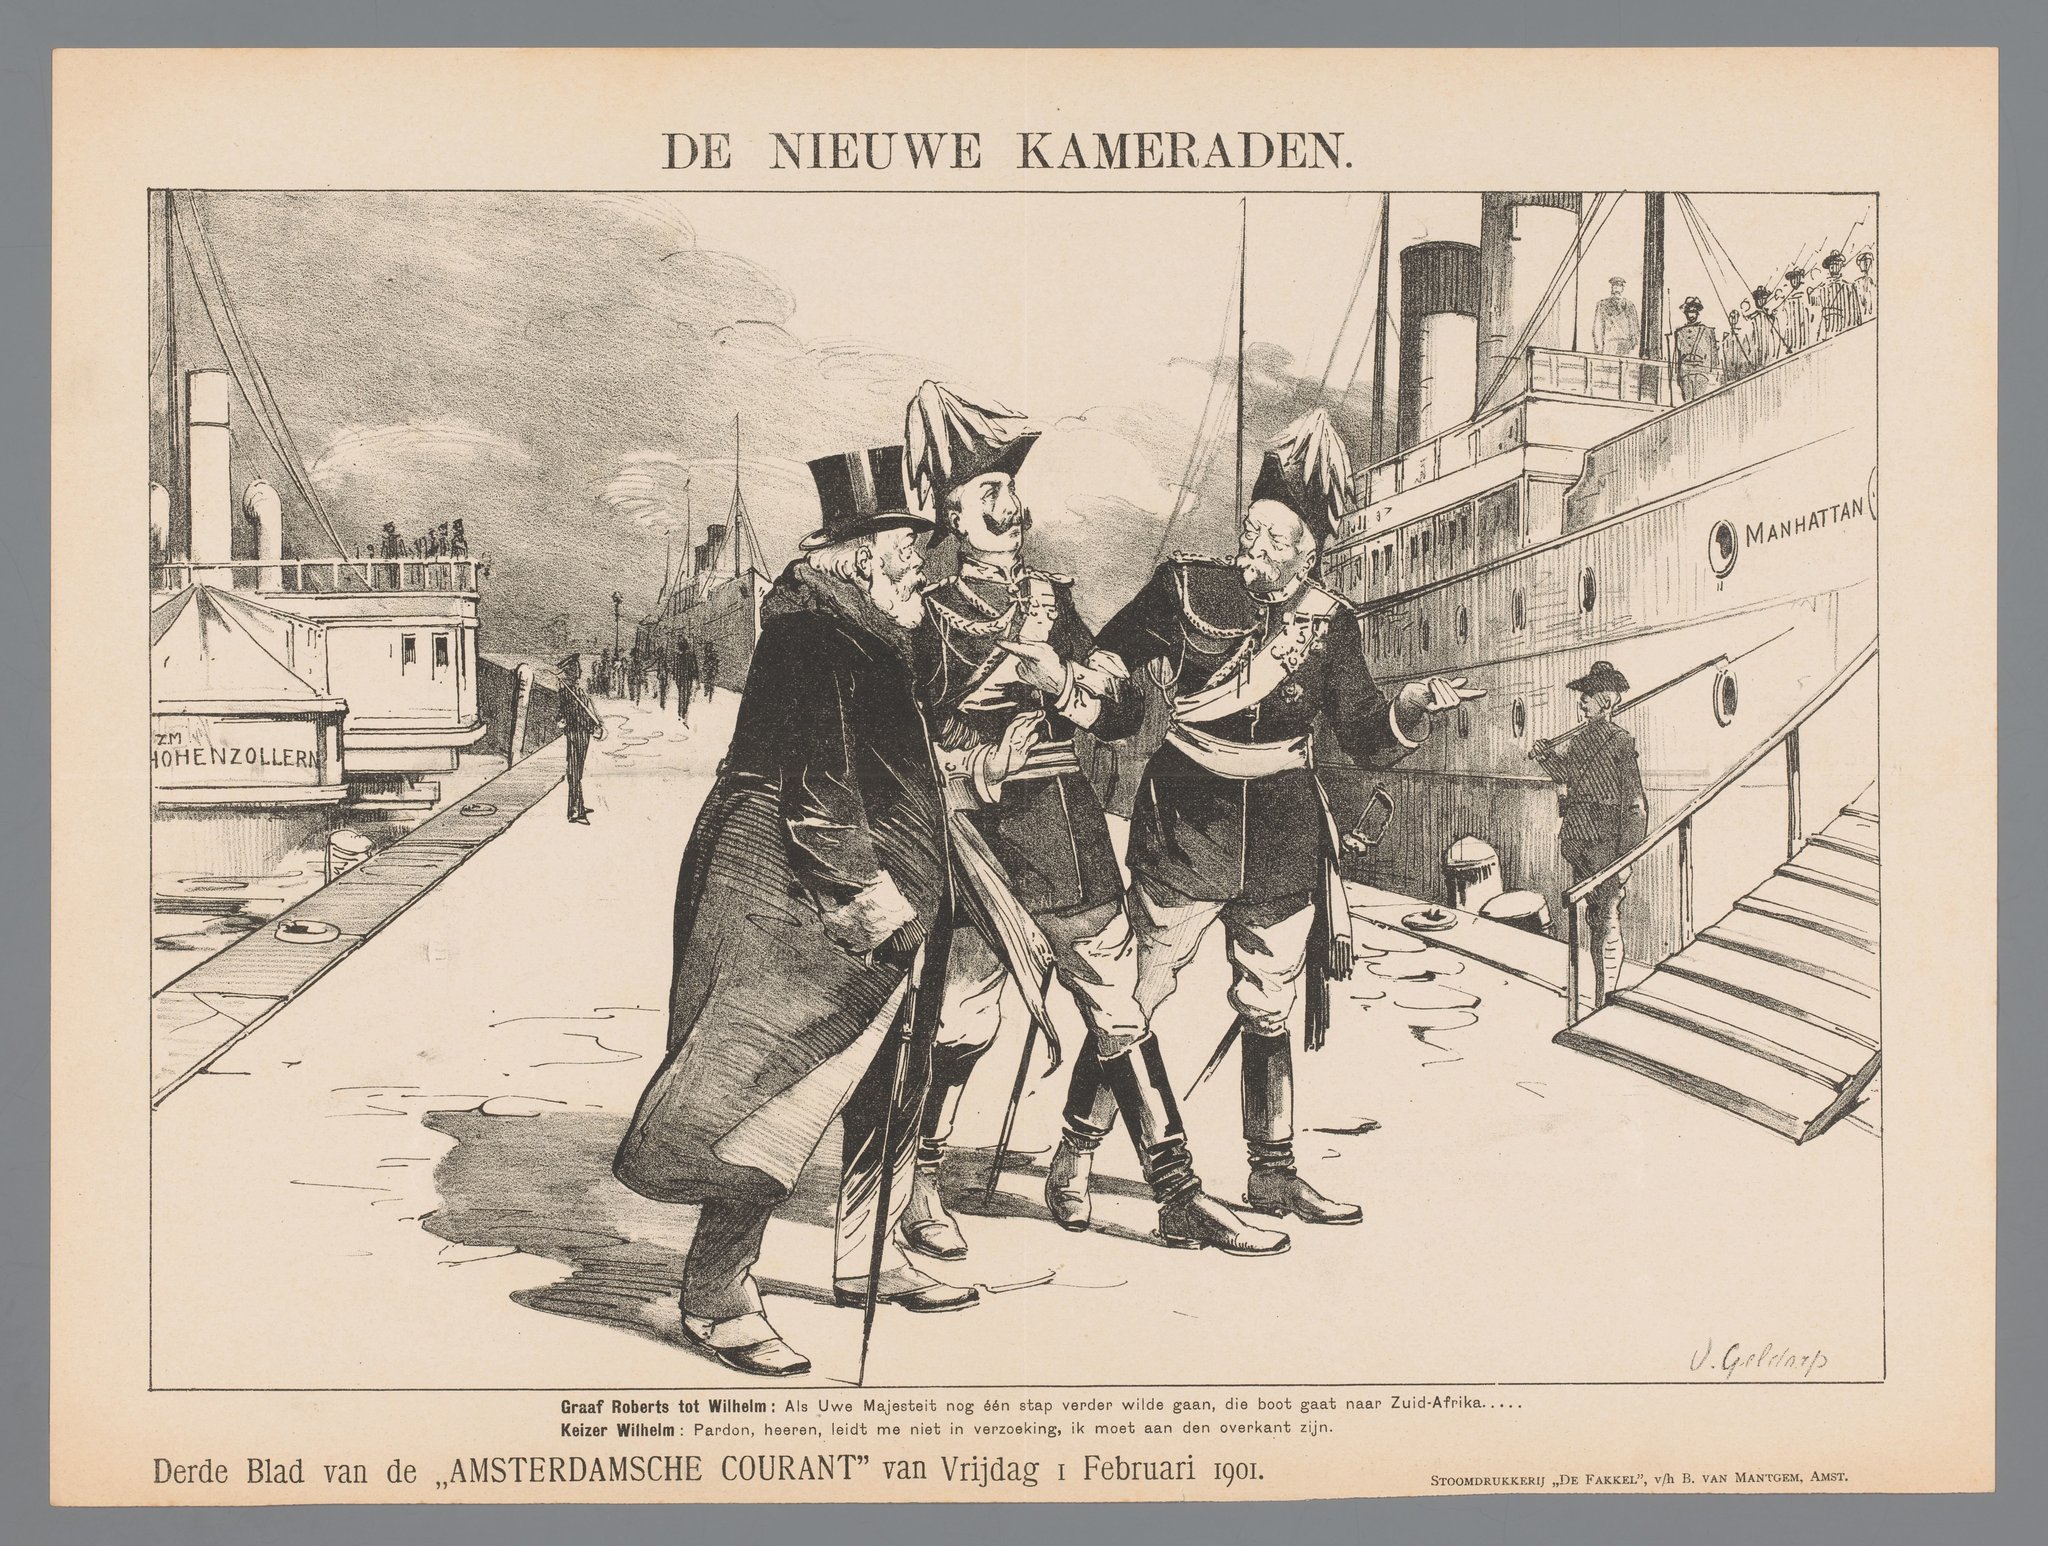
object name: cartoon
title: De nieuwe kameraden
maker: petrus van geldorp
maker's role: draughtsman, print maker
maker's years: 1872-1939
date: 1901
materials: paper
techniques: lithograph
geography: amsterdam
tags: wilhelm ii (keizer van duitsland), historical persons, ships (in general), emperor, political caricatures and satires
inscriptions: date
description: Prent uit het bijvoegsel van: De Amsterdamsche Courant, 1 februari 1901.